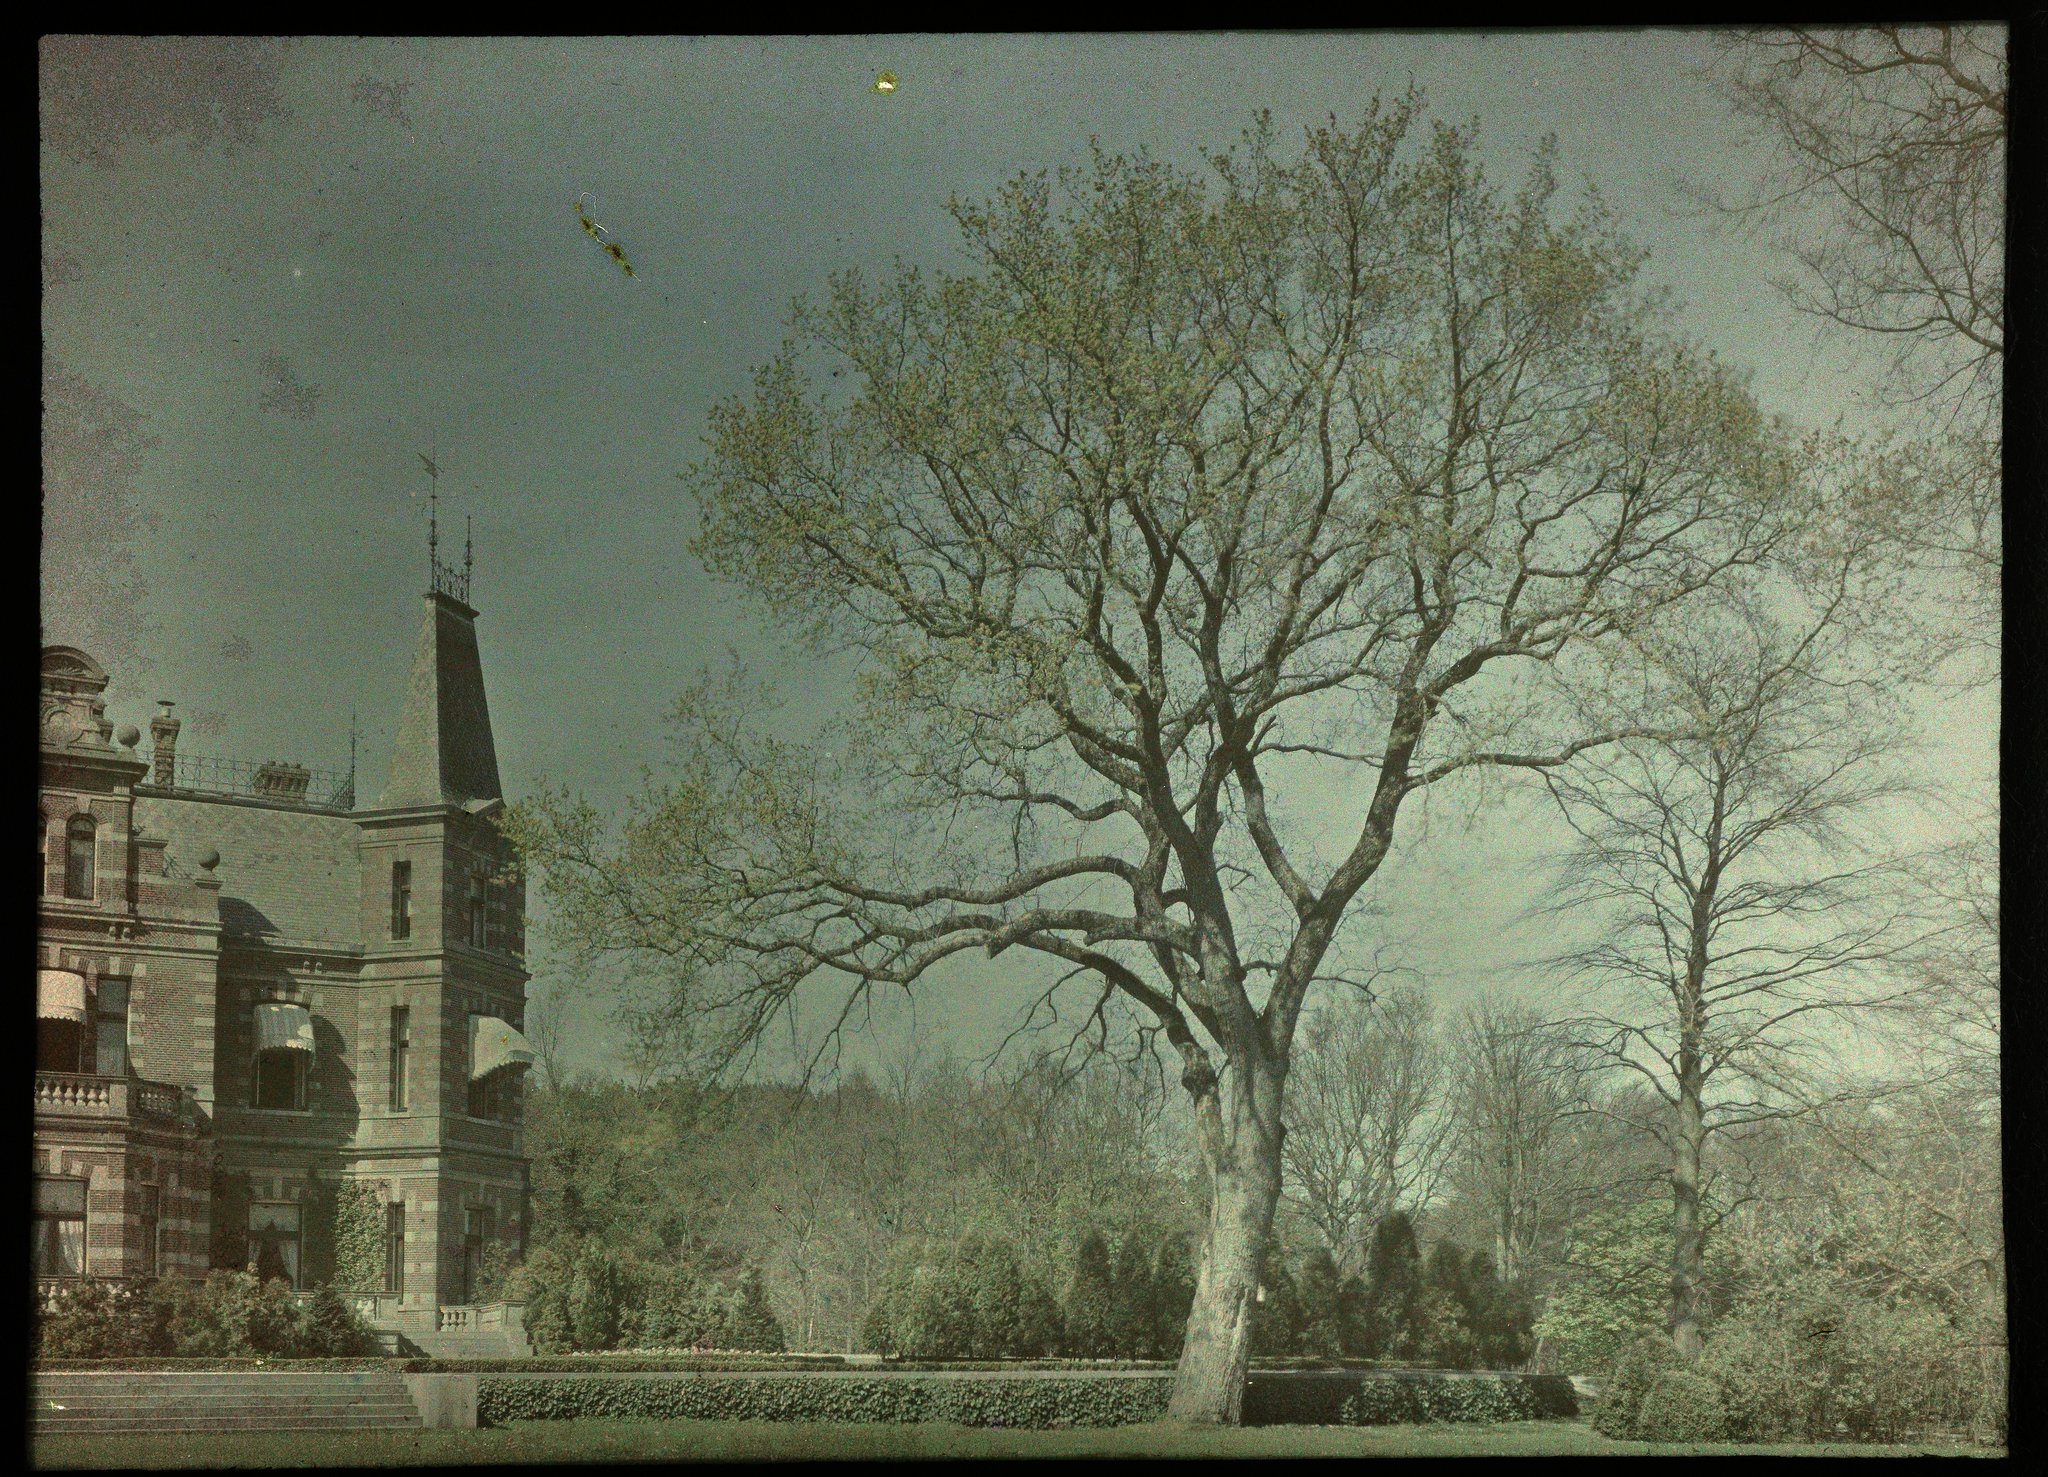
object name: glasdia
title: Gezicht op een landhuis (links) met park en kale bomen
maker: adolphe burdet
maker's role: fotograaf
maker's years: 1860-1940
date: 1907-1930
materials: glass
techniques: autochrome process, slide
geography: netherlands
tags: overveen